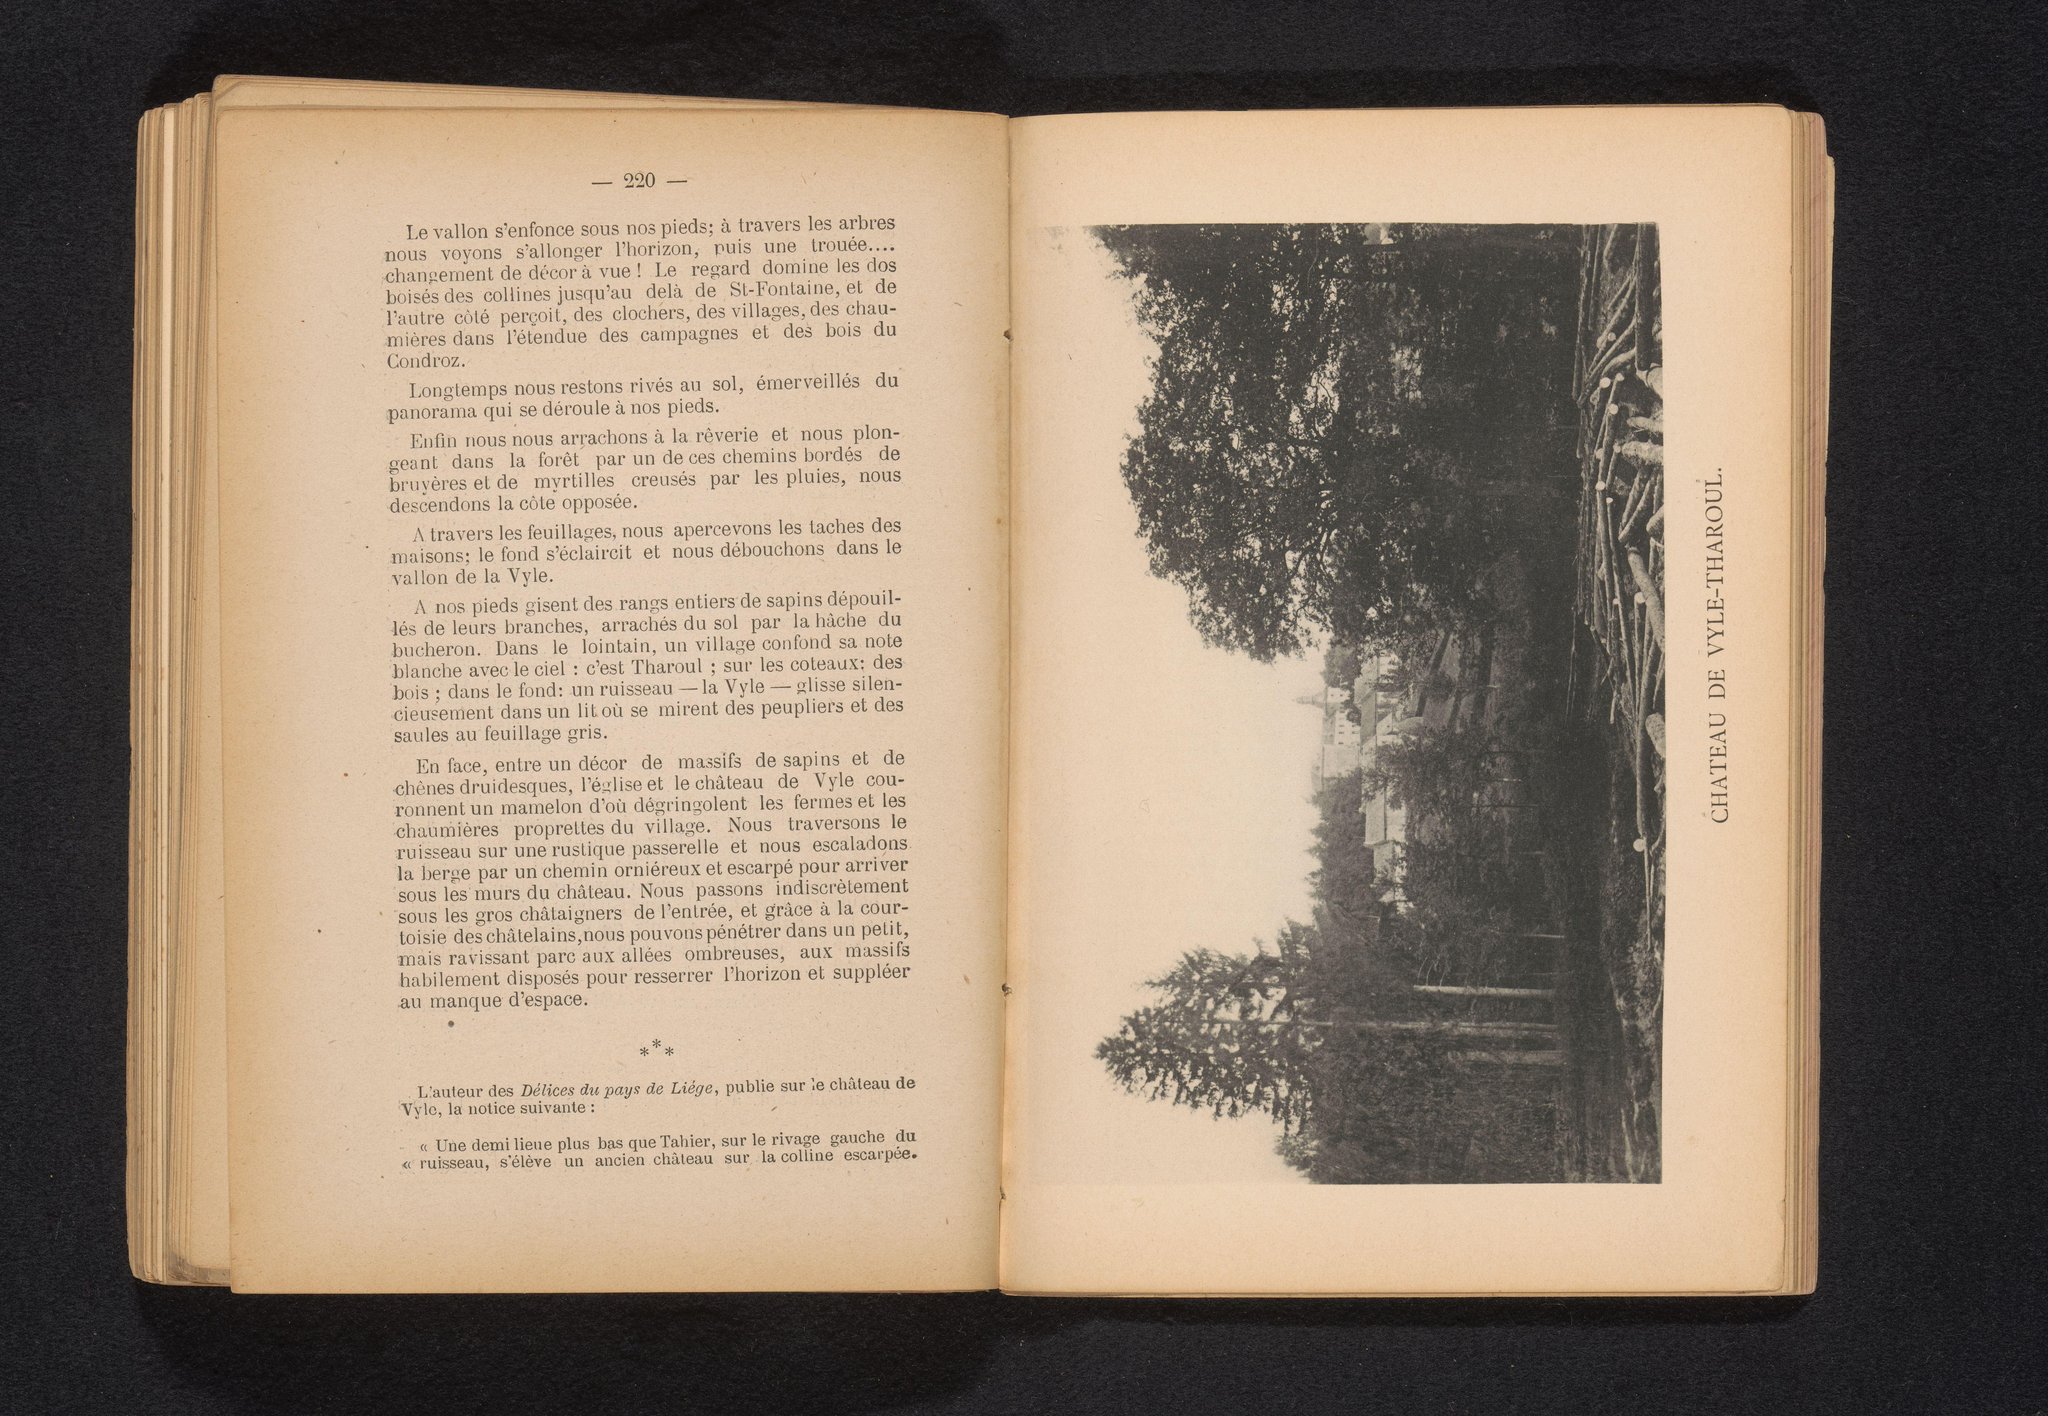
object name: photomechanical print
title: Landschap met Château de Vyle-Tharoul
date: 1885-1890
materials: paper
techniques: photograph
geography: brussels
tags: castle, liège